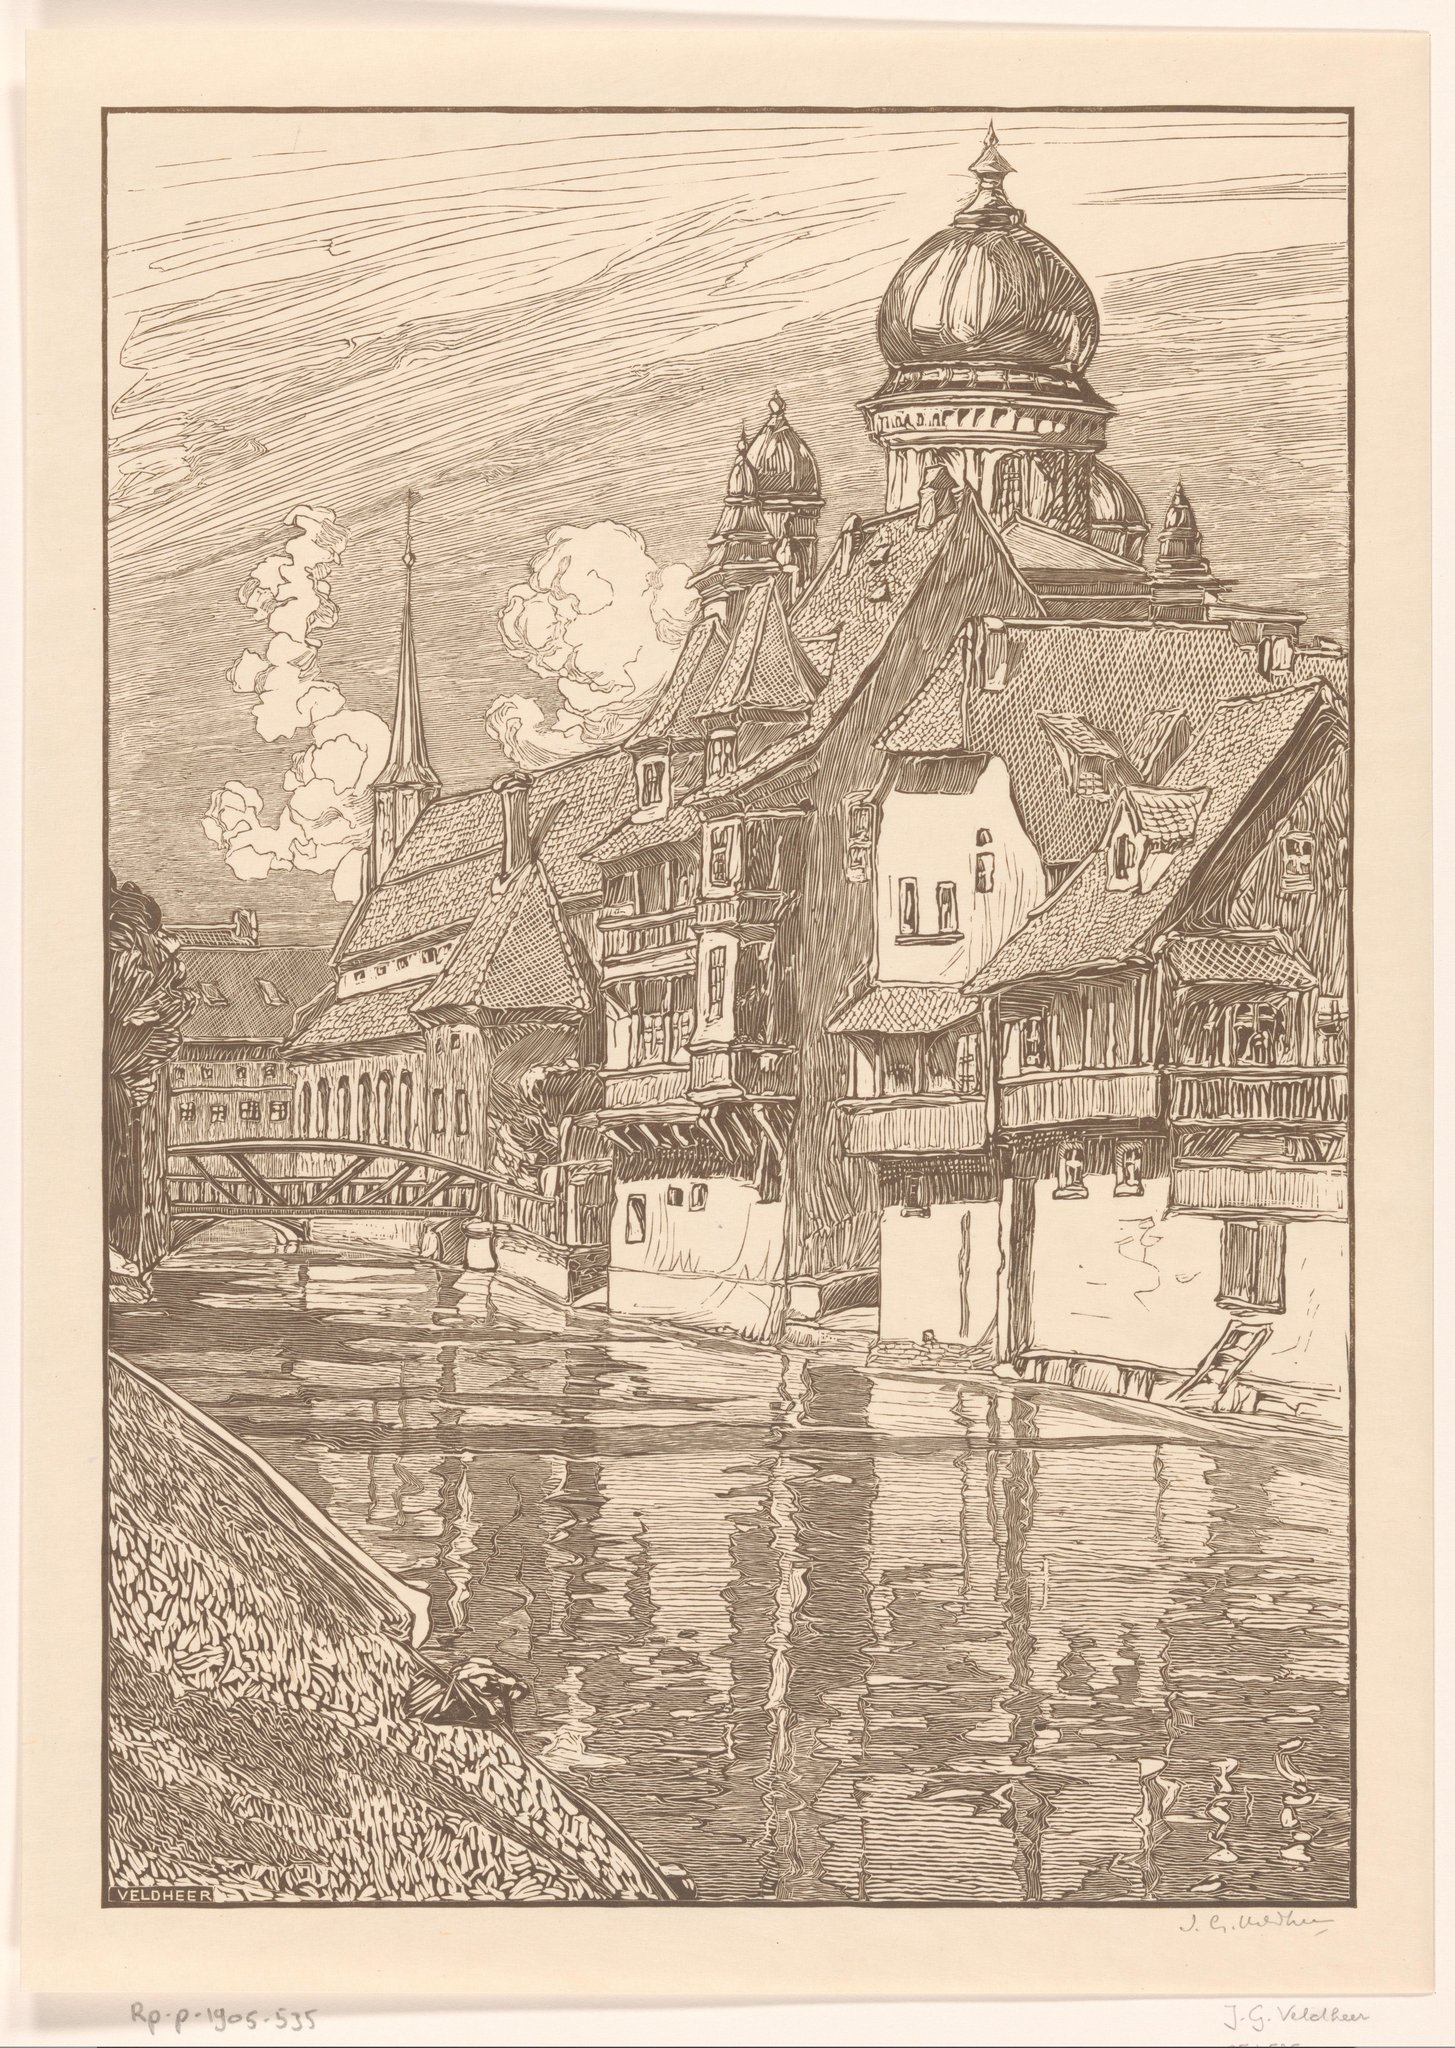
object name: print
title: Gezicht op de synagoge van Neurenberg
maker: jacobus gerardus veldheer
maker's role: draughtsman, print maker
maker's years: 1866-1954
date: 1876-1905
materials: paper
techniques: woodcut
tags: the synagogue (as building and place of worship ~ jewish religion)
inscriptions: collector's mark: Lugt 2228